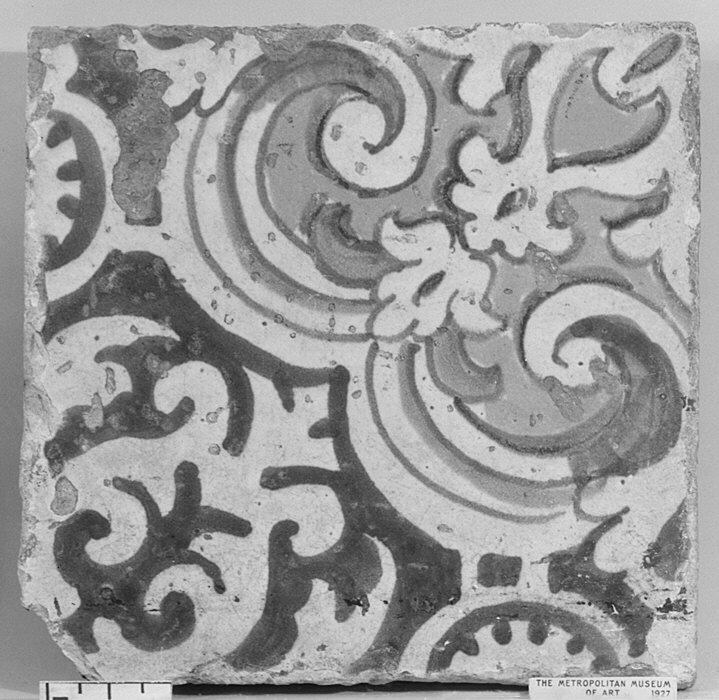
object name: tile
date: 1580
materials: earthenware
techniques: glazing